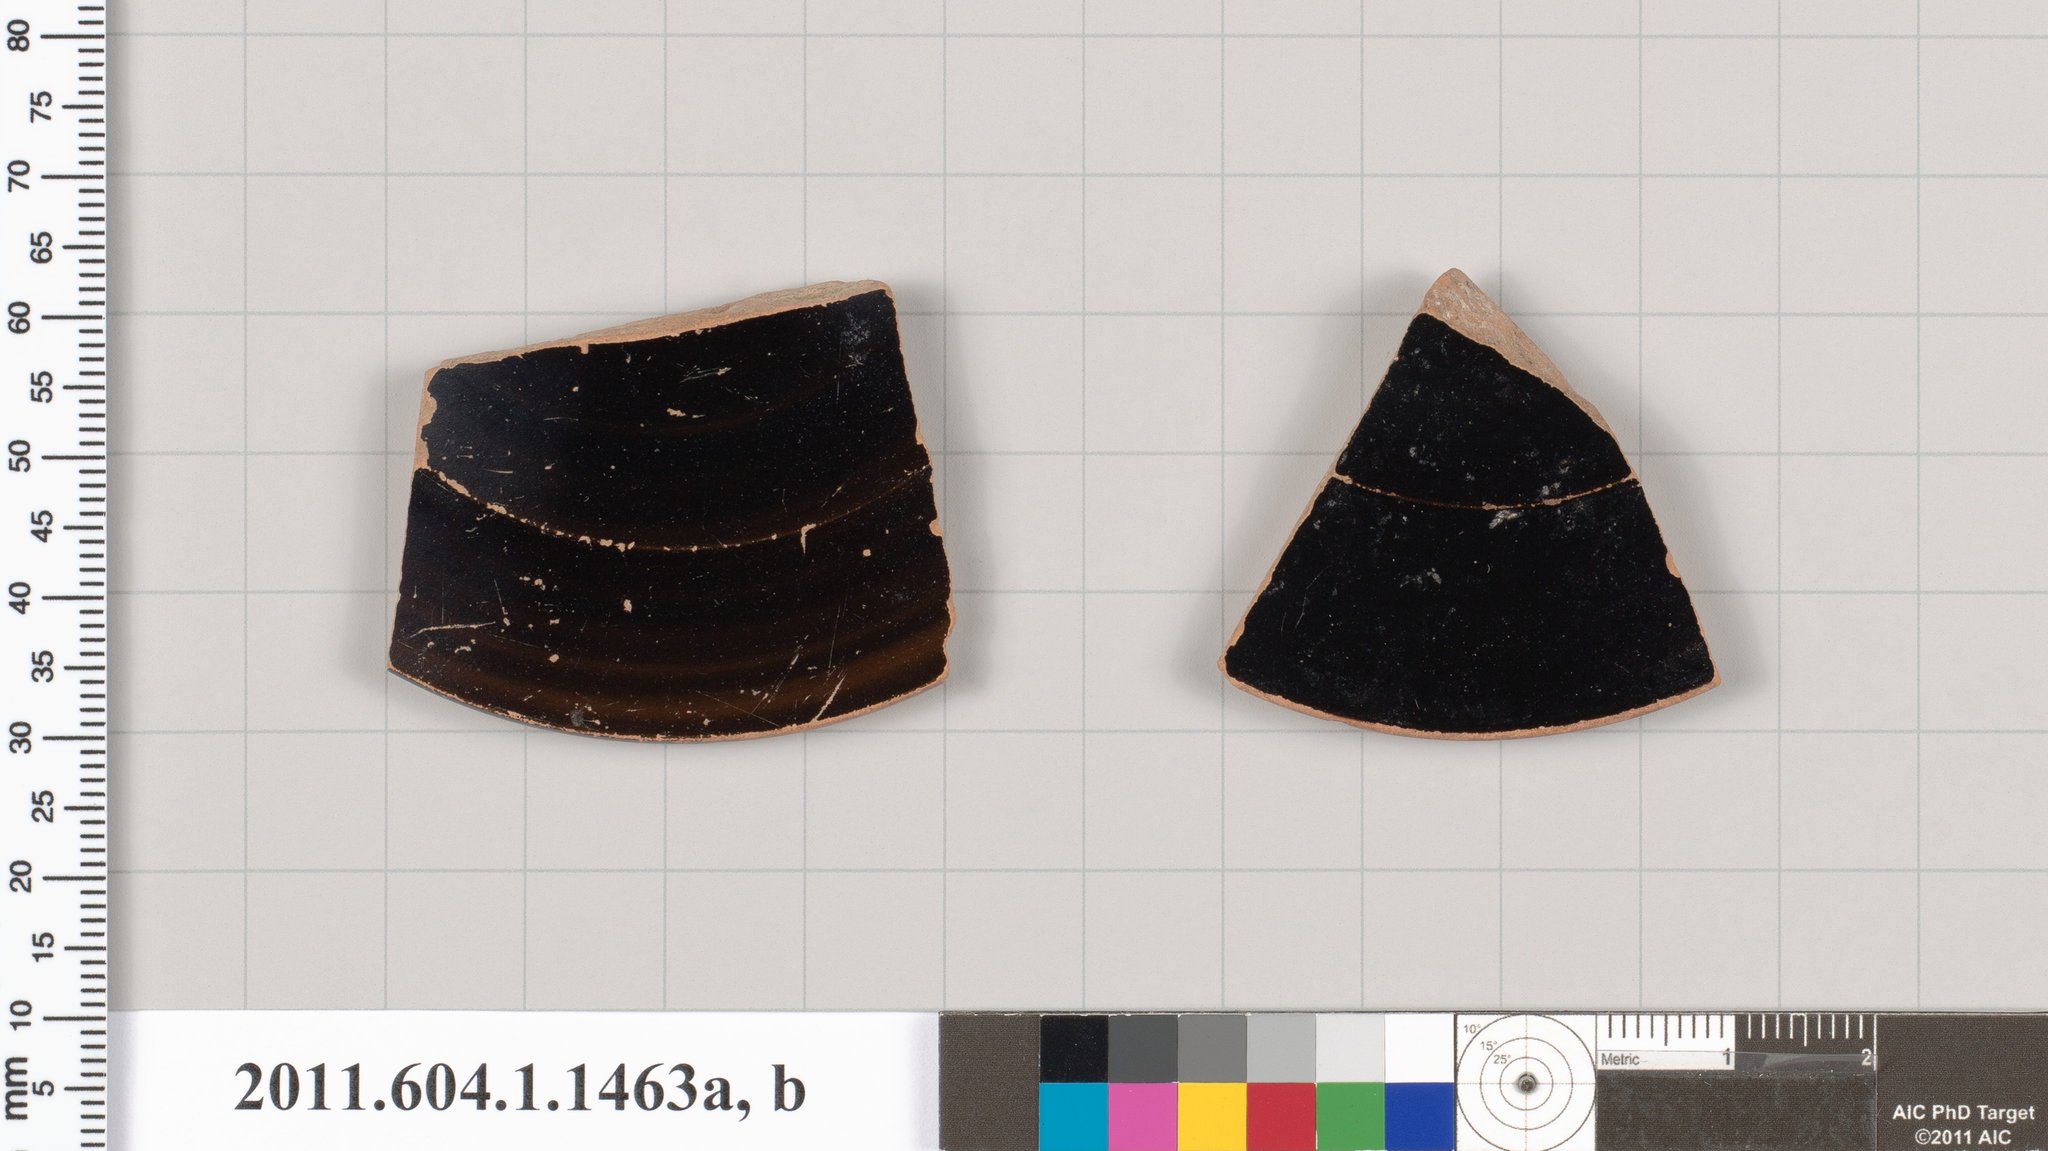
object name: kylix fragment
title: Terracotta fragments of kylikes (drinking cups)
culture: greek, attic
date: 500-401 BCE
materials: terracotta